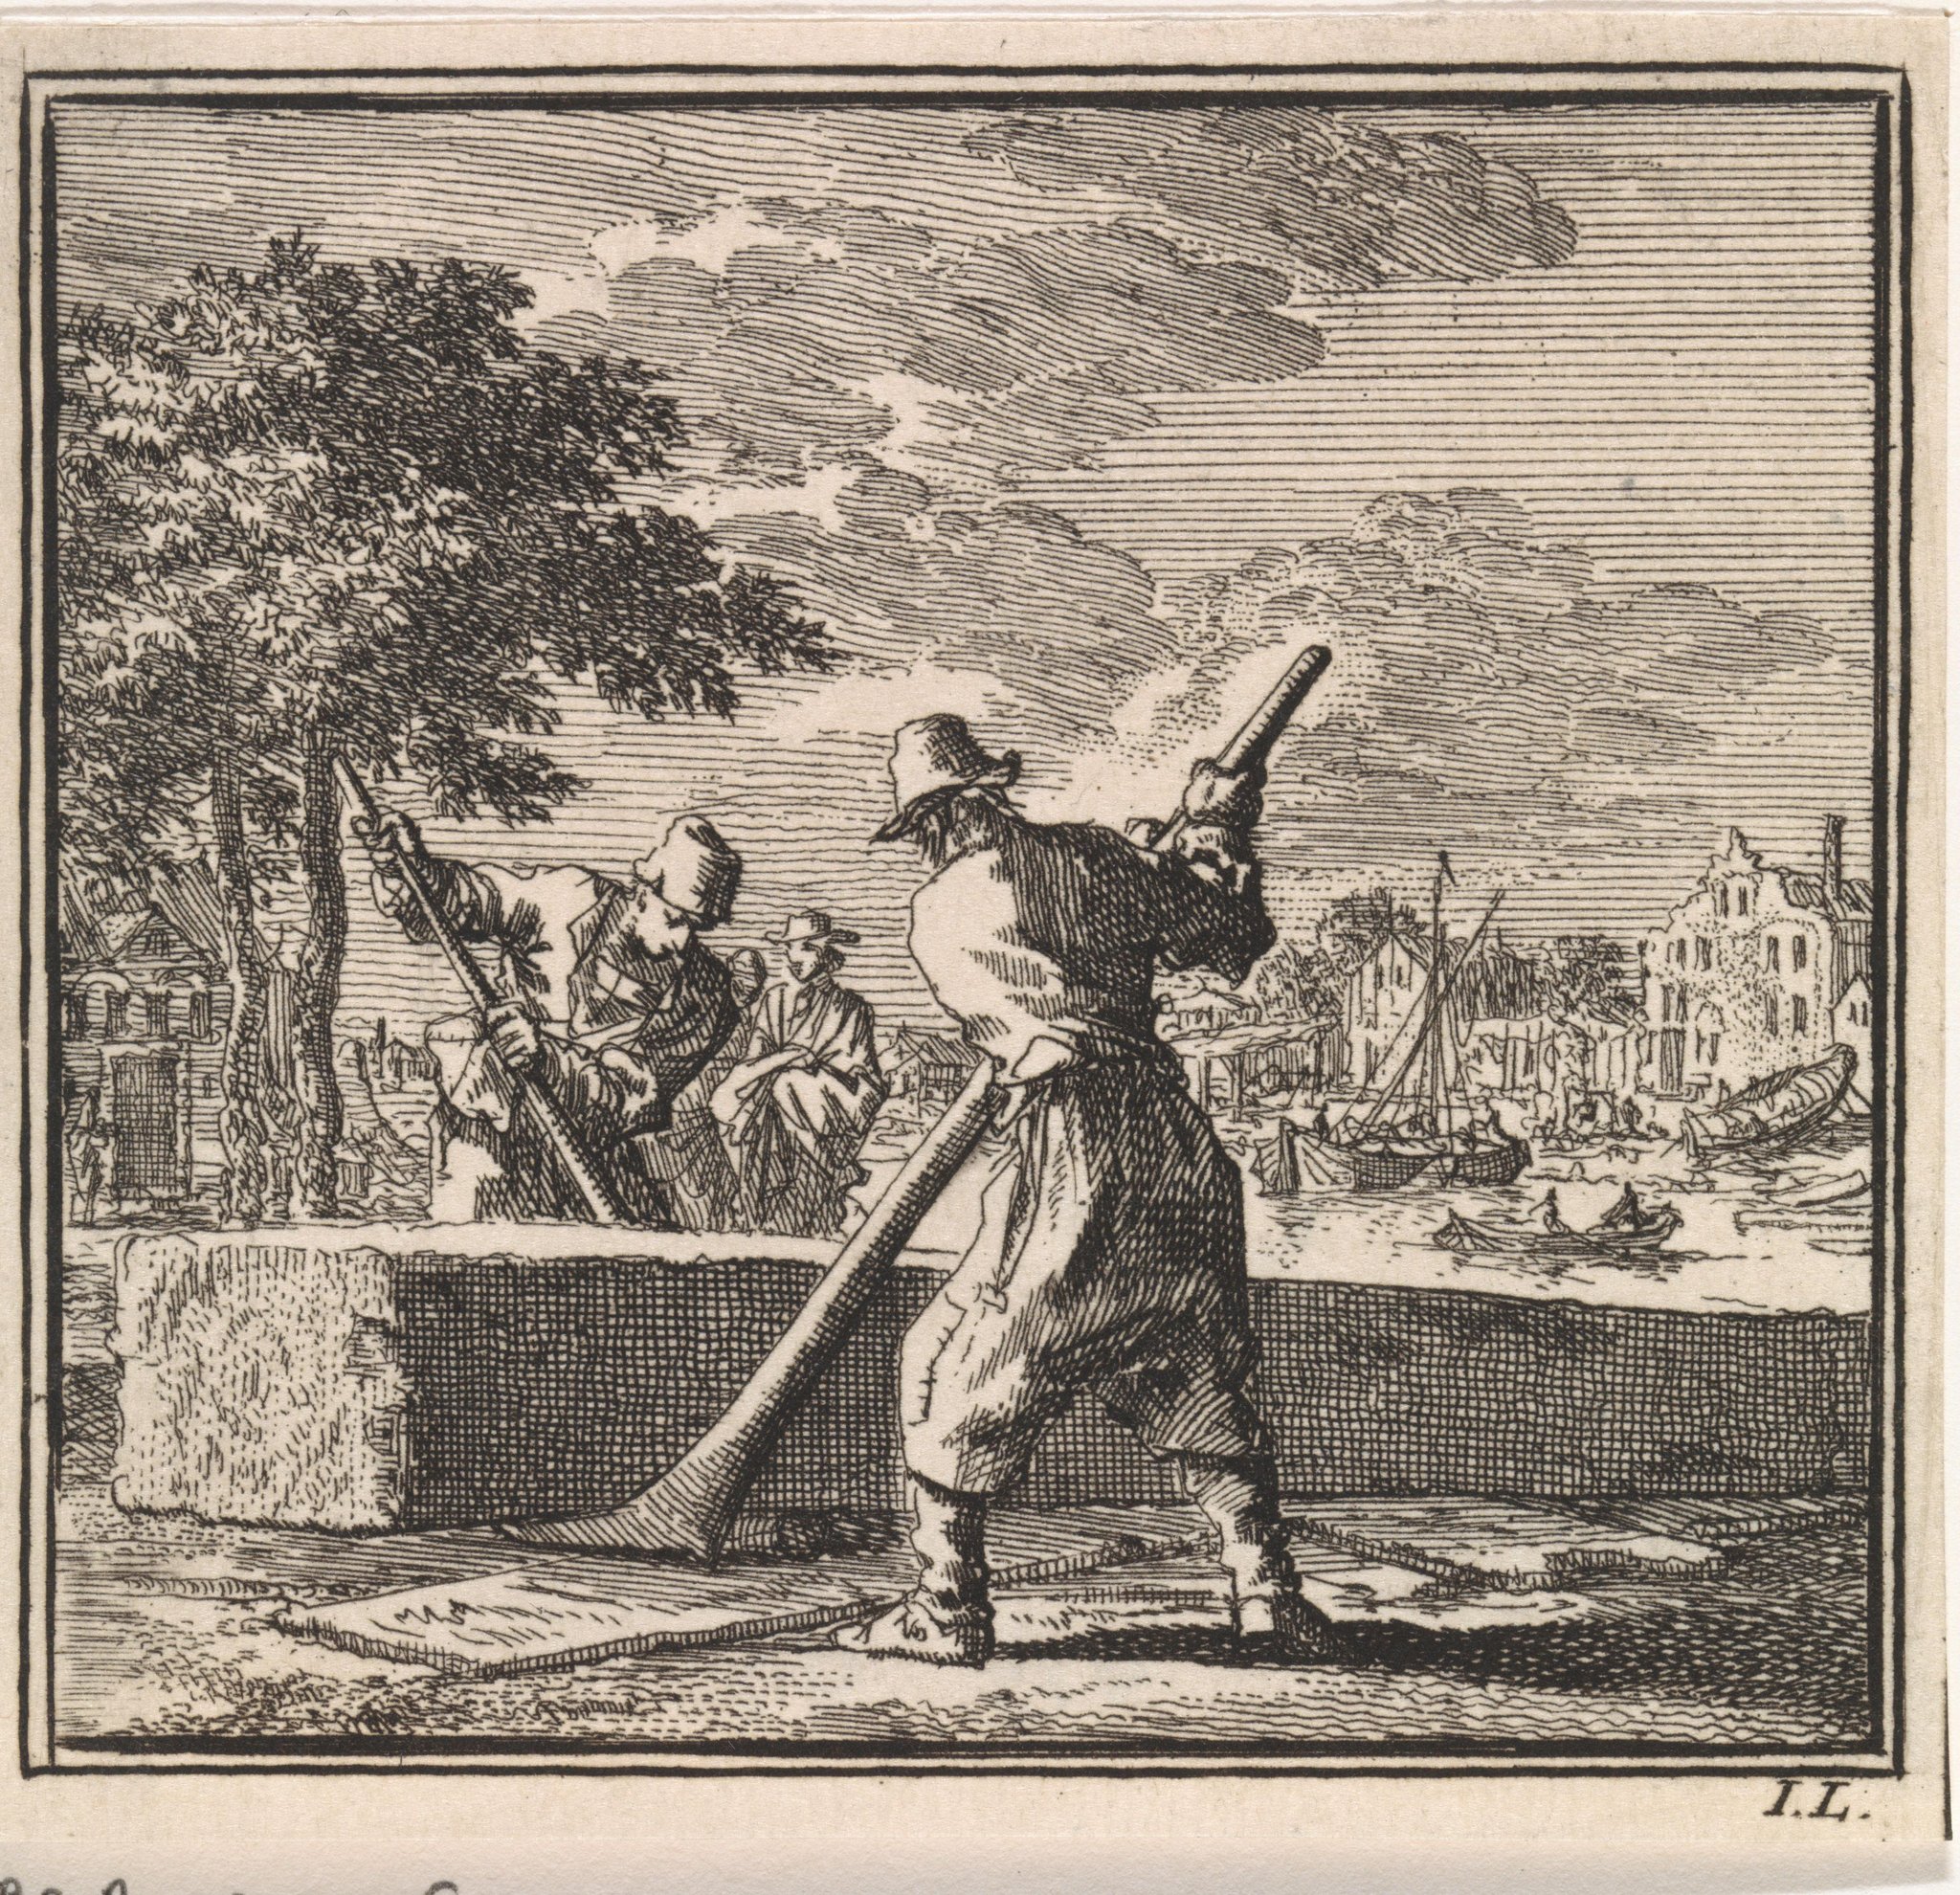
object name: print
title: Twee mannen verplaatsen een balk met hefbomen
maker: jan luyken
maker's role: draughtsman, print maker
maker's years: 1649-1712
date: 1711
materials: paper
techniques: etching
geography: amsterdam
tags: beam, log of wood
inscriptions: collector's mark: Lugt 2228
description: Illustratie voor: Luyken, Jan. De Bykorf des Gemoeds. Amsterdam: Pieter Arentsz. II (wed.) en Cornelis van der Sys, 1711, p. 258.